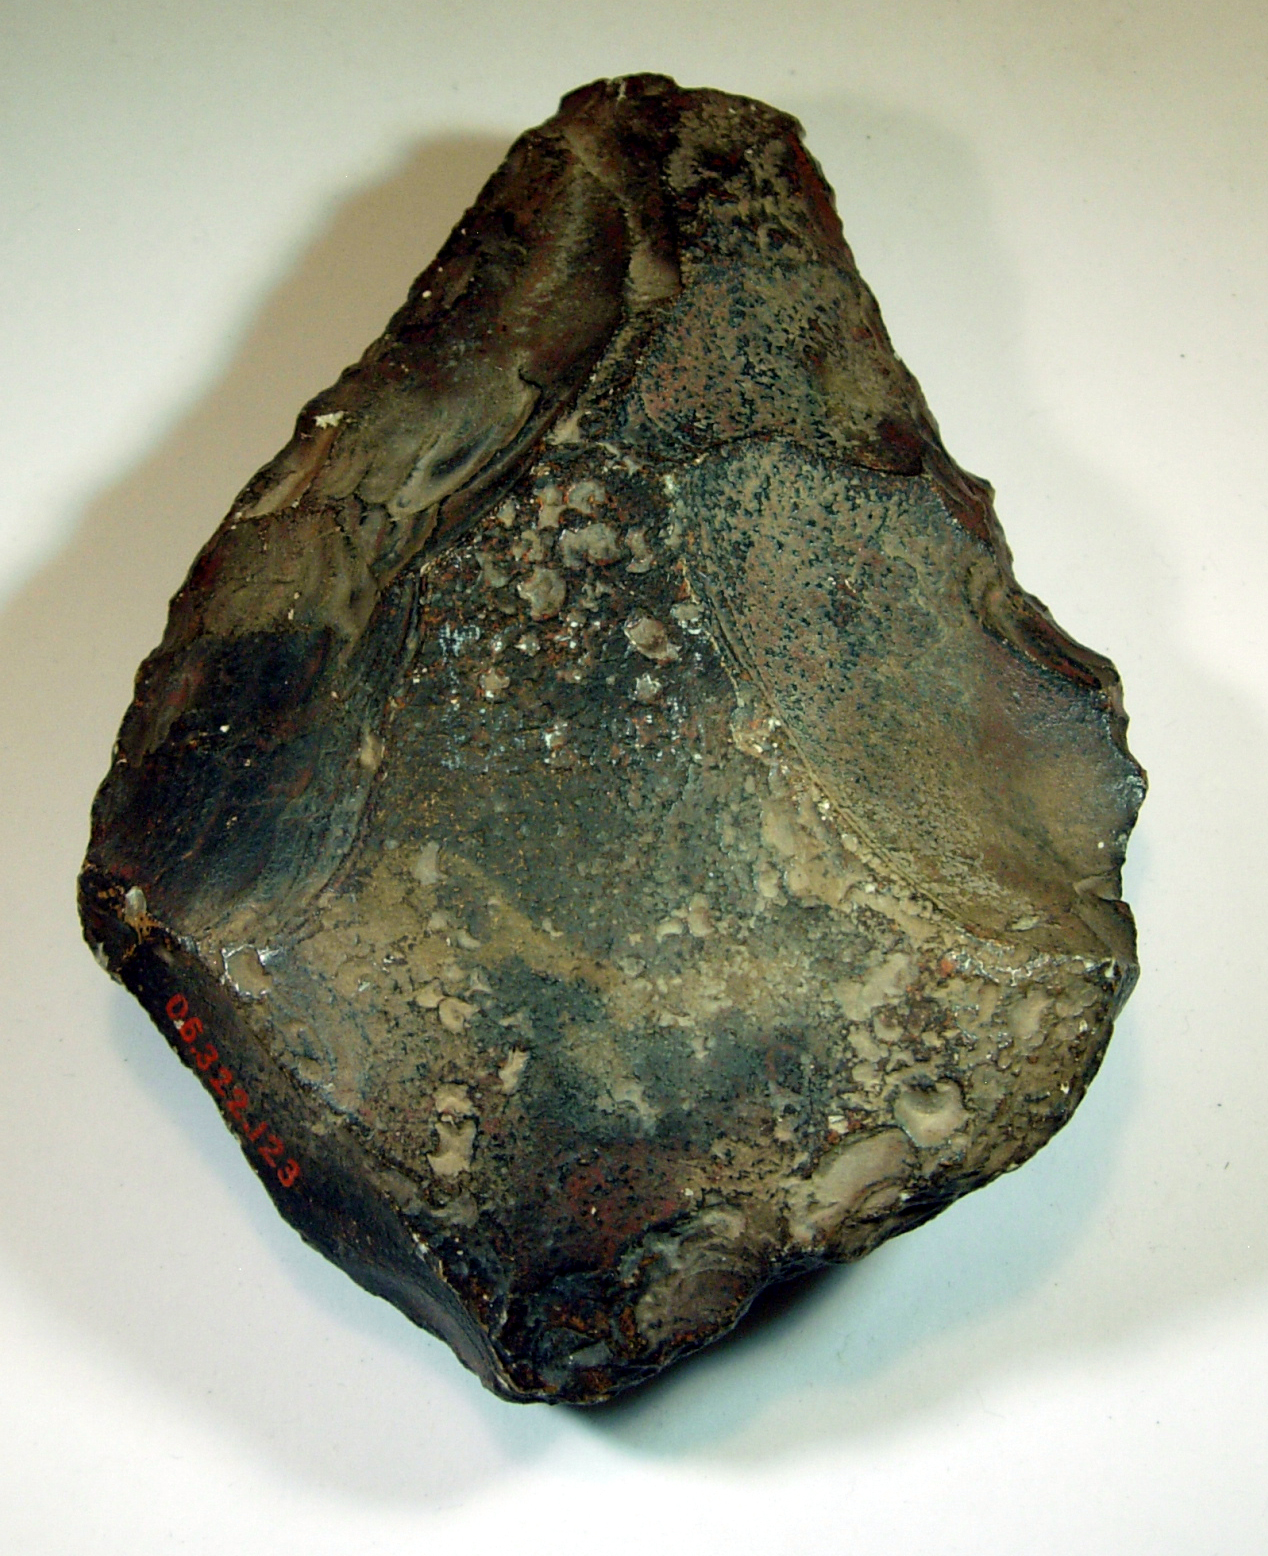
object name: tool, biface, hand ax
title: Biface, commonly referred to as a hand ax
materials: stone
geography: egypt